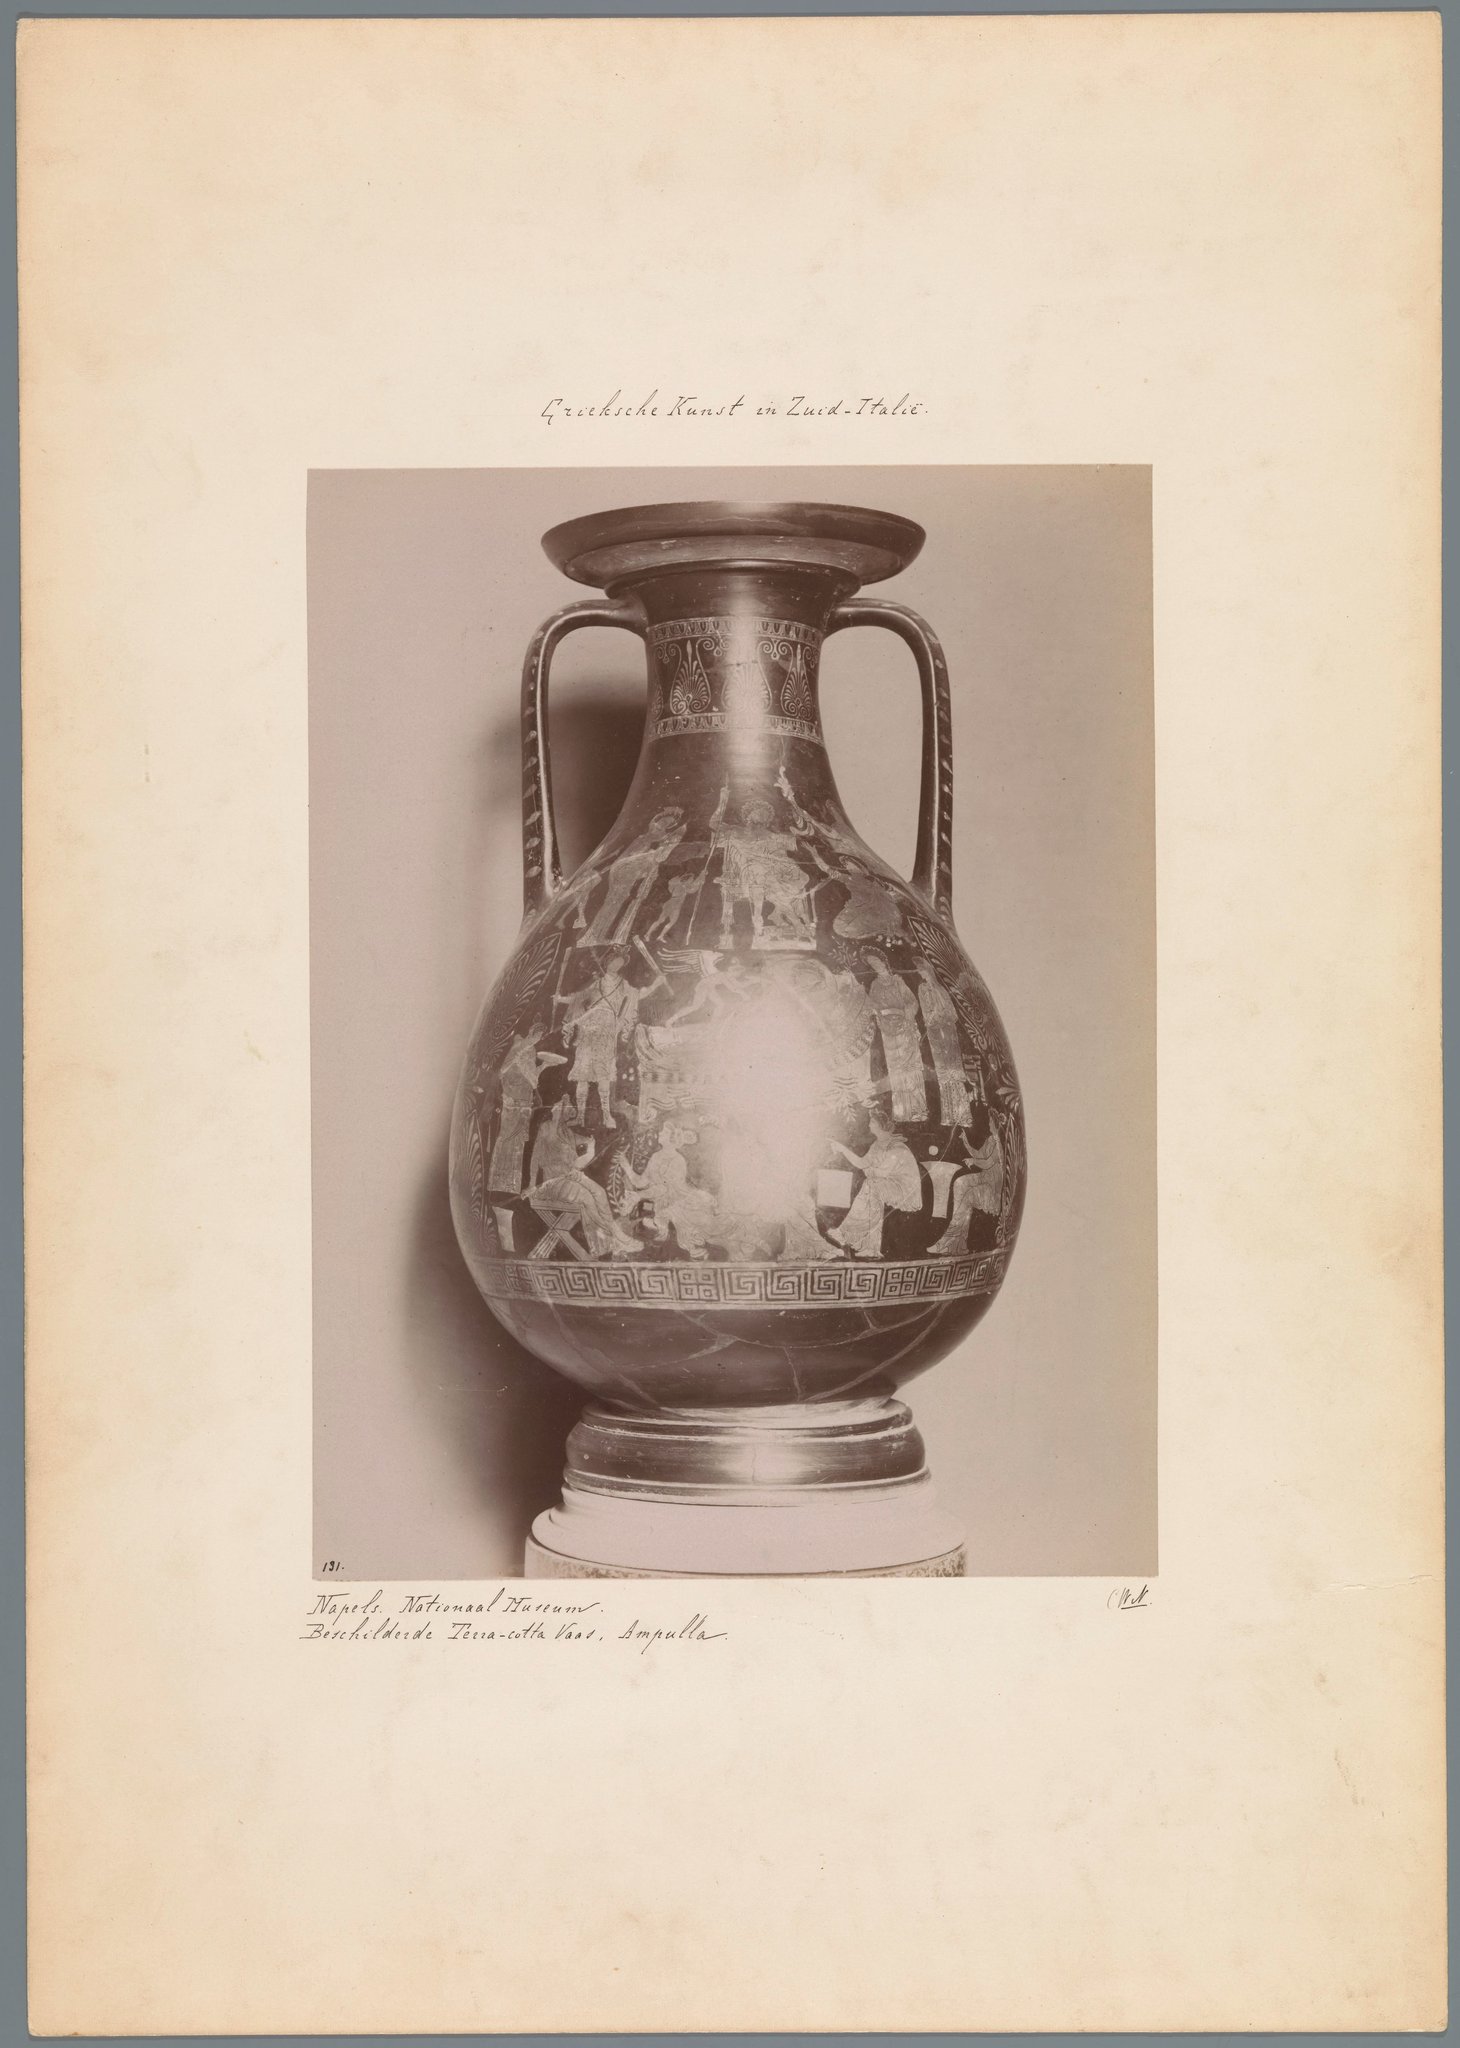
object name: photograph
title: Beschilderde terracotta vaas in het Museo Nazionale te Napels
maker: Anonymous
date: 1875-1900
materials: cardboard, photographic support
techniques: albumen print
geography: naples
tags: container of ceramics: jar, jug, pot, vase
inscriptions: number: ‘131.’, inscription: ‘CWN.’, collector's mark: ‘KUNSTNIJVERHEIDSCHOOL QUELLINUS AMSTERDAM FRANS HALSSTRAAT 14.’, collector's mark: ‘INSTITUUT VOOR KUNST- NIJVERHEIDSONDERWIJS GABRIËL METSUSTRAAT No. 16. AMSTERDAM’, inscription: ‘Grieksche Kunst in Zuid-Italië. Napels. Nationaal Museum. Beschilderde Terra-cotta Vaas, Ampulla.’